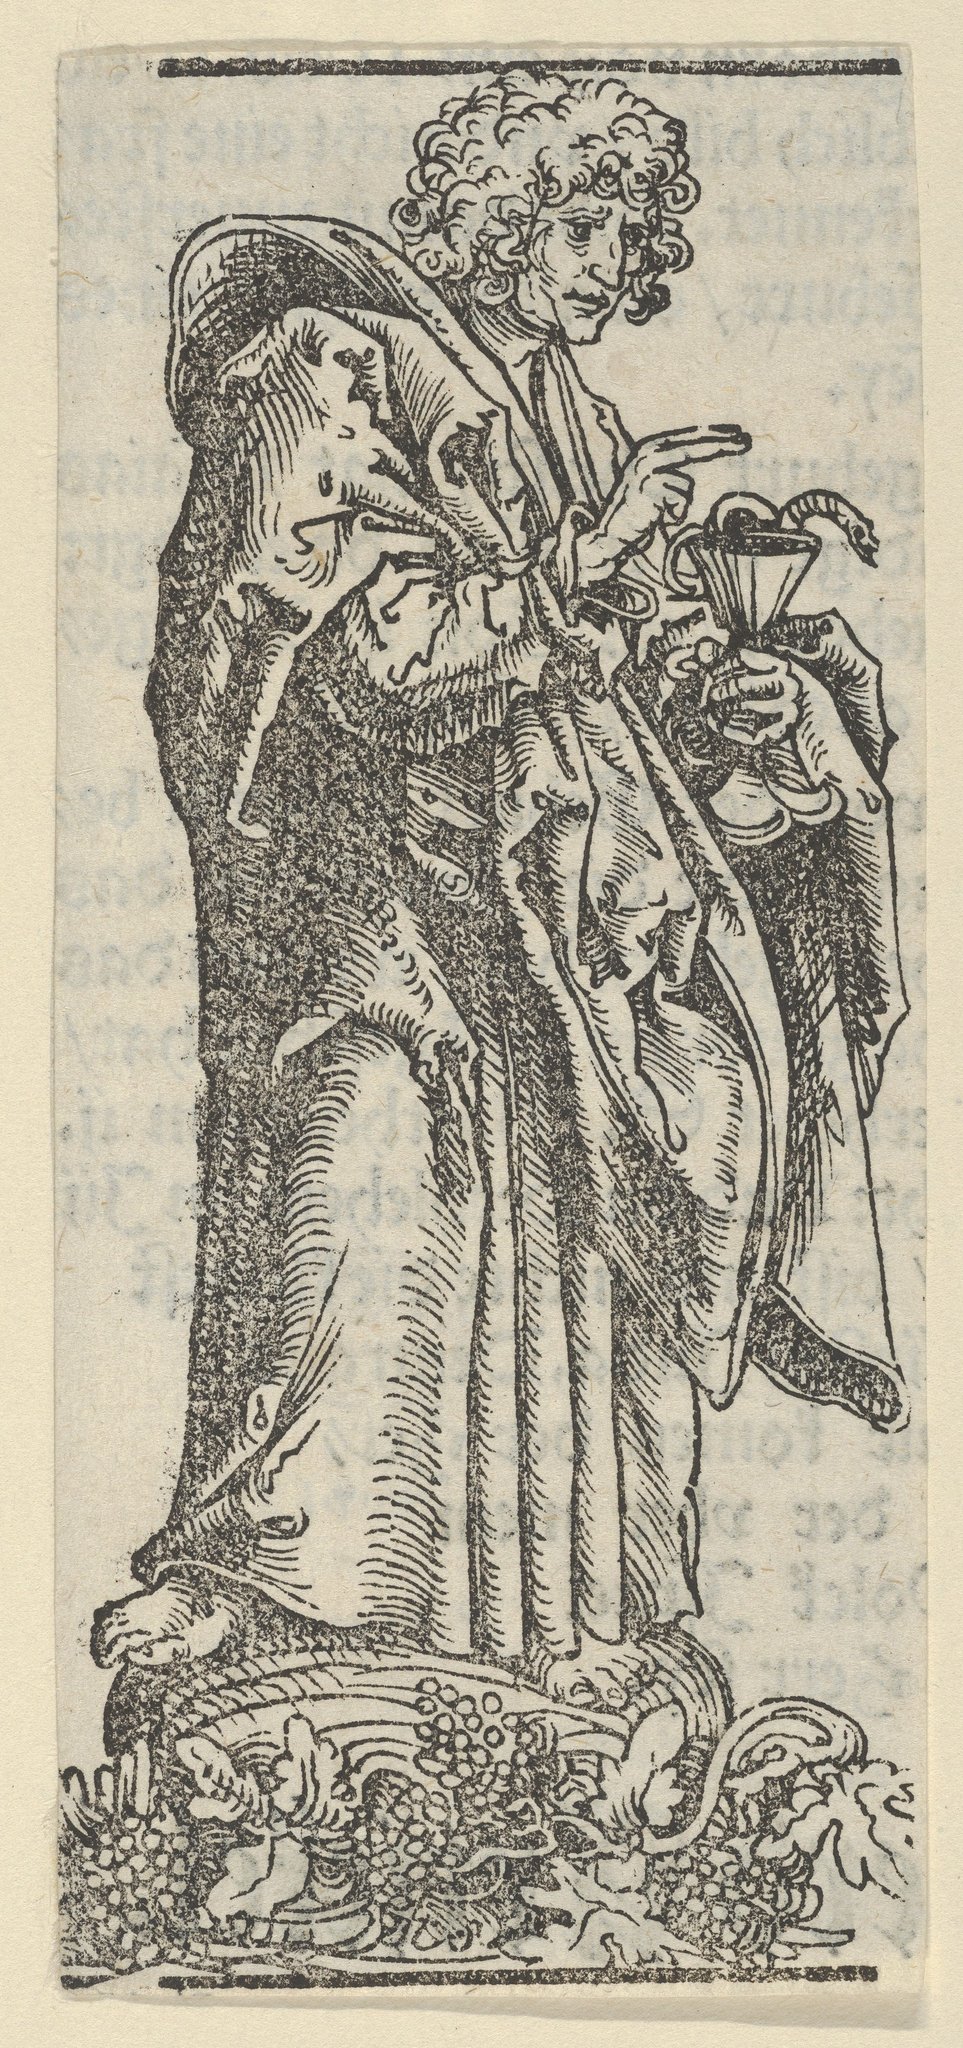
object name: print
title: Silver Statuette of St. John the Baptist from the Wittenberg Reliquaries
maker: lucas cranach the elder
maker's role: artist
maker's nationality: german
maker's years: 1472-1553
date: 1472-1553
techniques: woodcut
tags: saint john the baptist